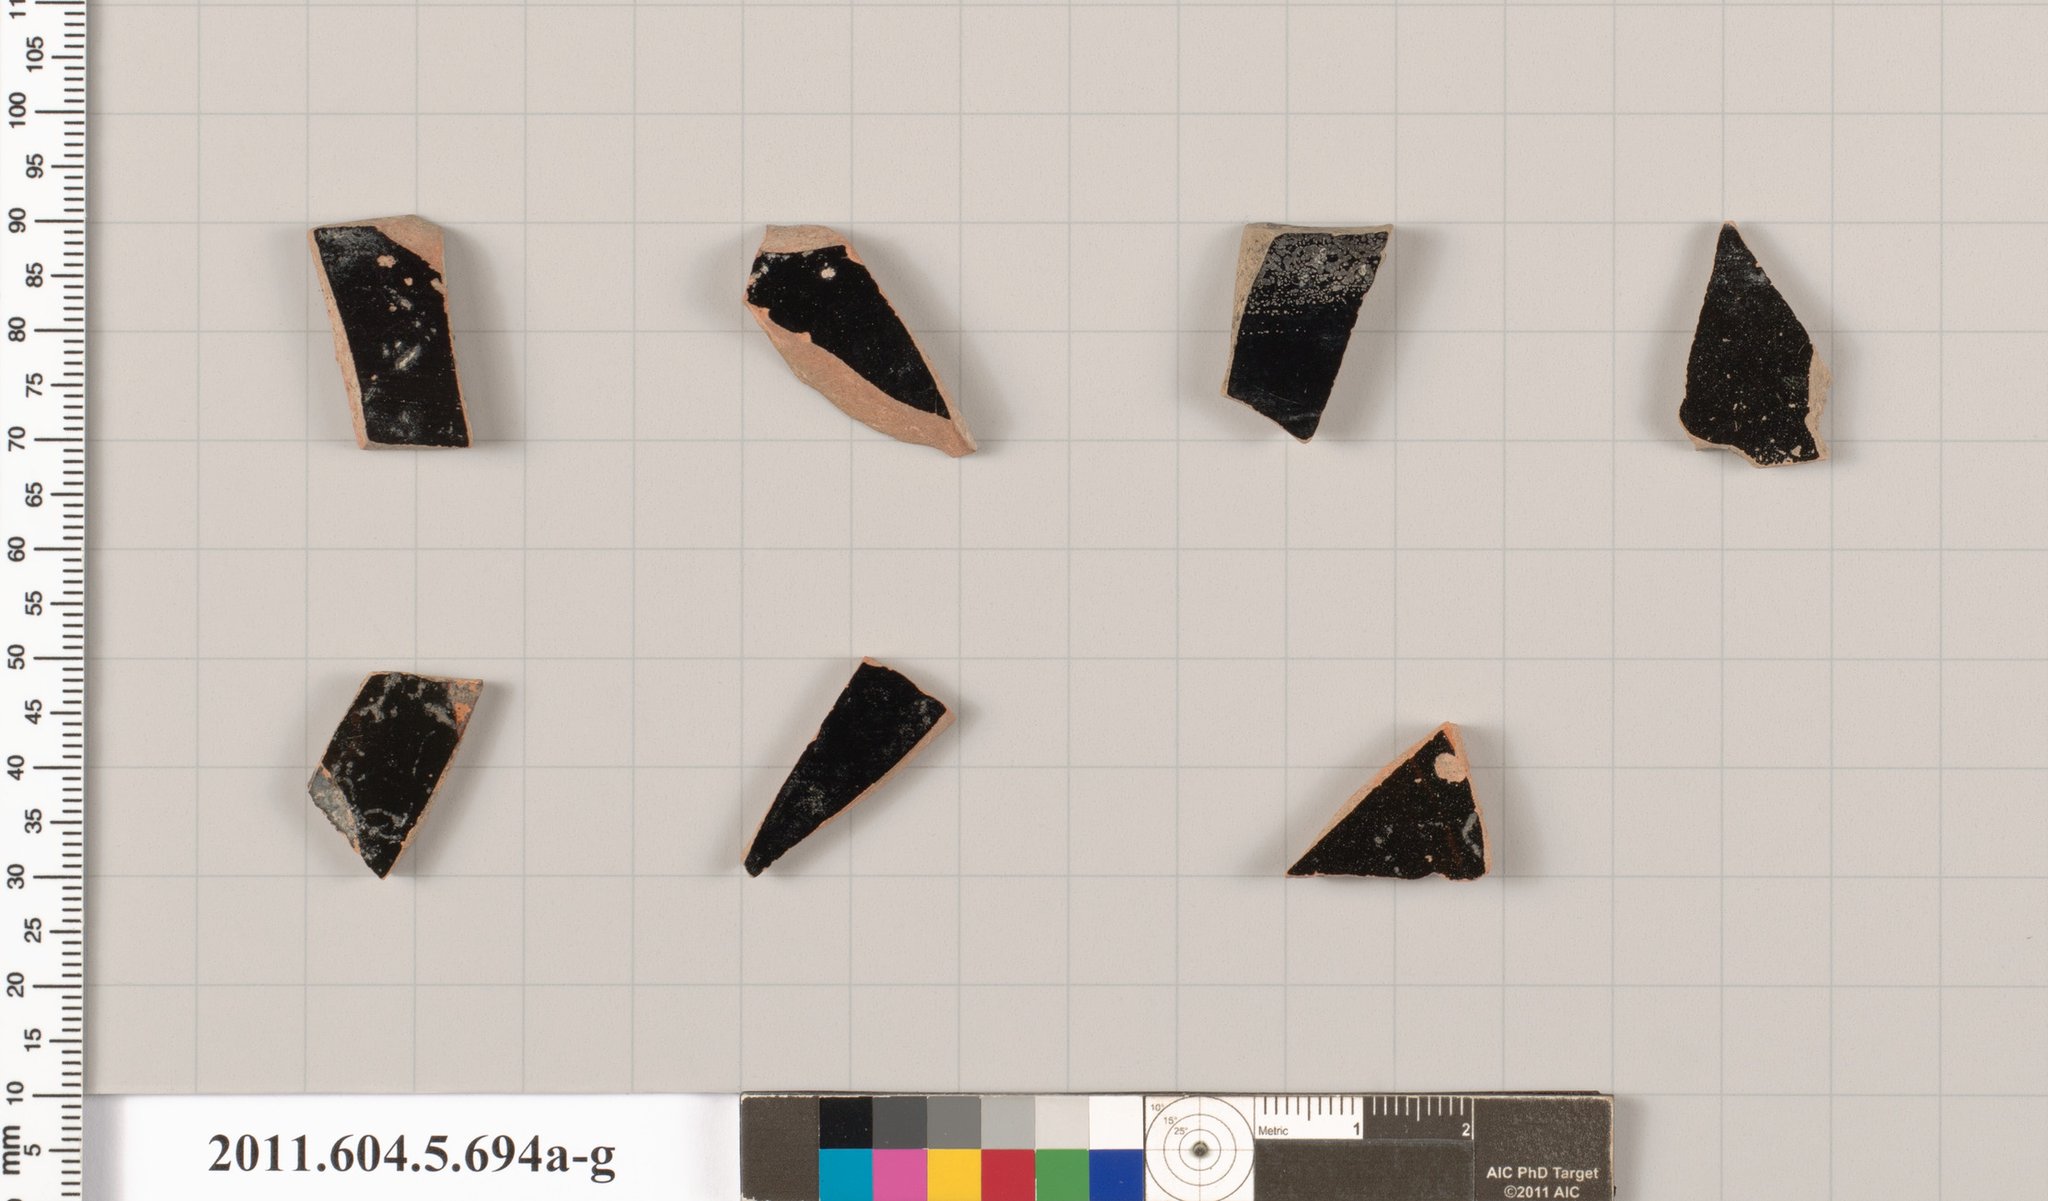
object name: kylix fragment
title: Terracotta fragments of kylikes (drinking cups)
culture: greek, attic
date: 600-401 BCE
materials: terracotta